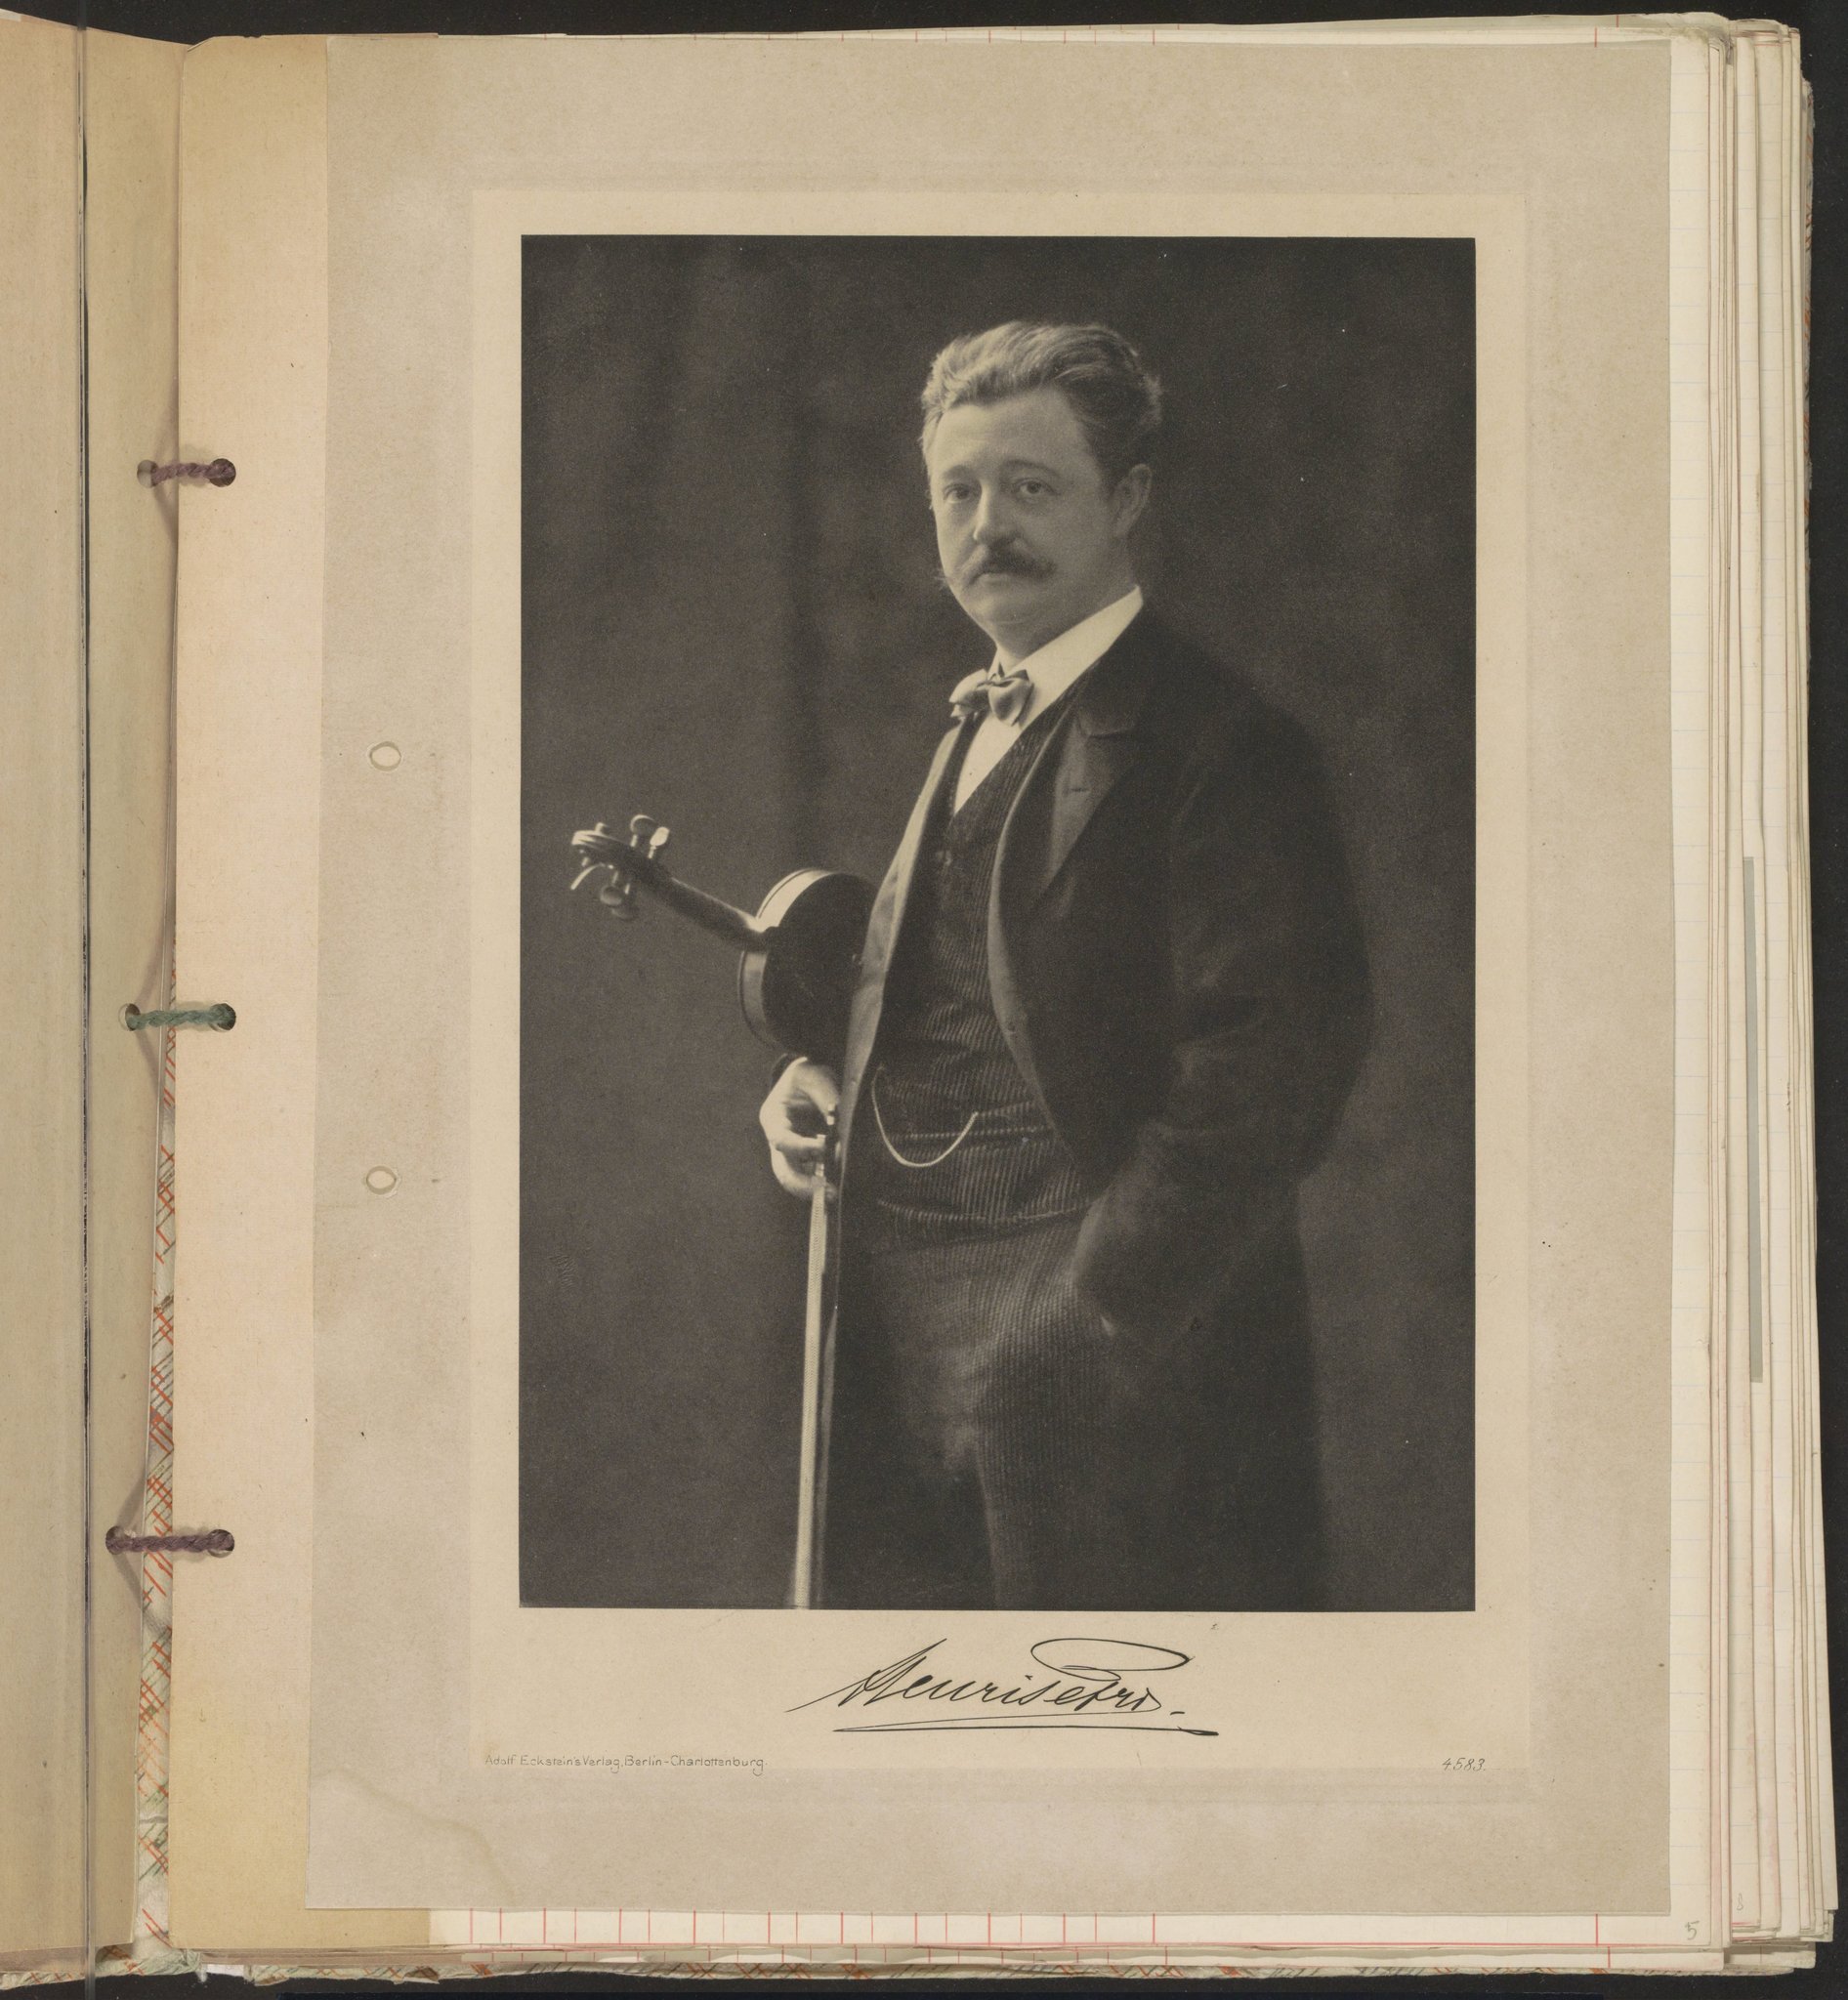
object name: album leaf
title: Portret van musicus Henri W. Petri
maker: Anonymous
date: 1890-1910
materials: cardboard, paper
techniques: photoaquatint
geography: charlottenburg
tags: making music; musician with instrument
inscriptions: number: ‘4583’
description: Onderdeel van Fotoalbum van de familie Petri.